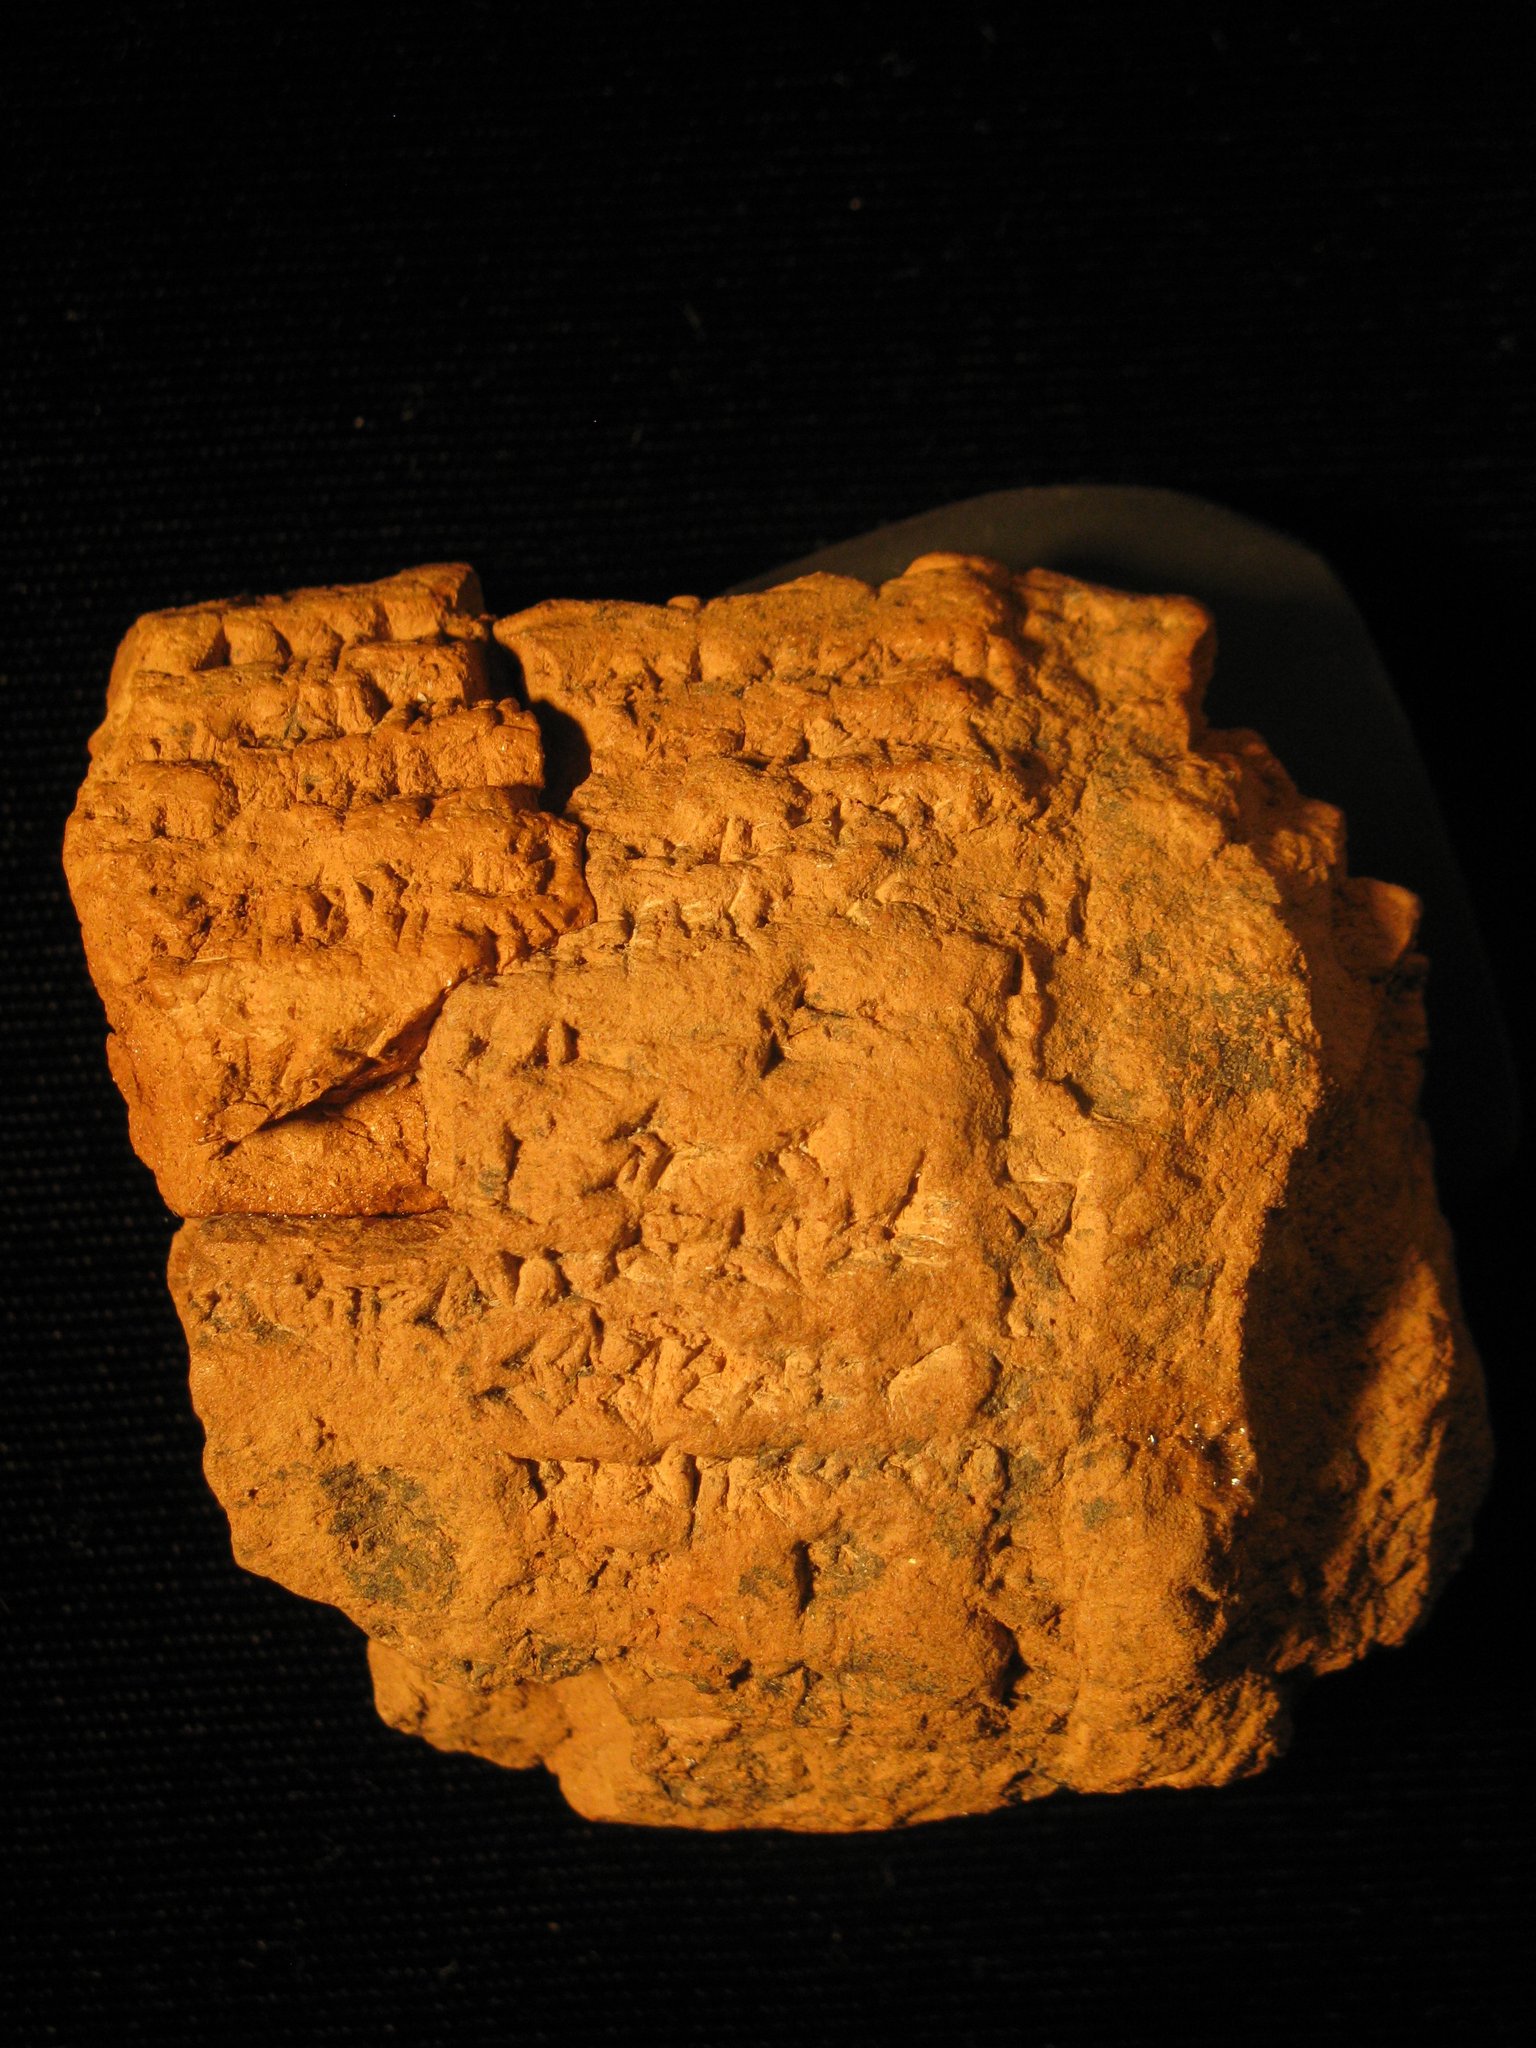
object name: cuneiform cylinder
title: Fragment of a solid clay barrel cylinder inscribed with an unidentified hymn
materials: clay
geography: mesopotamia